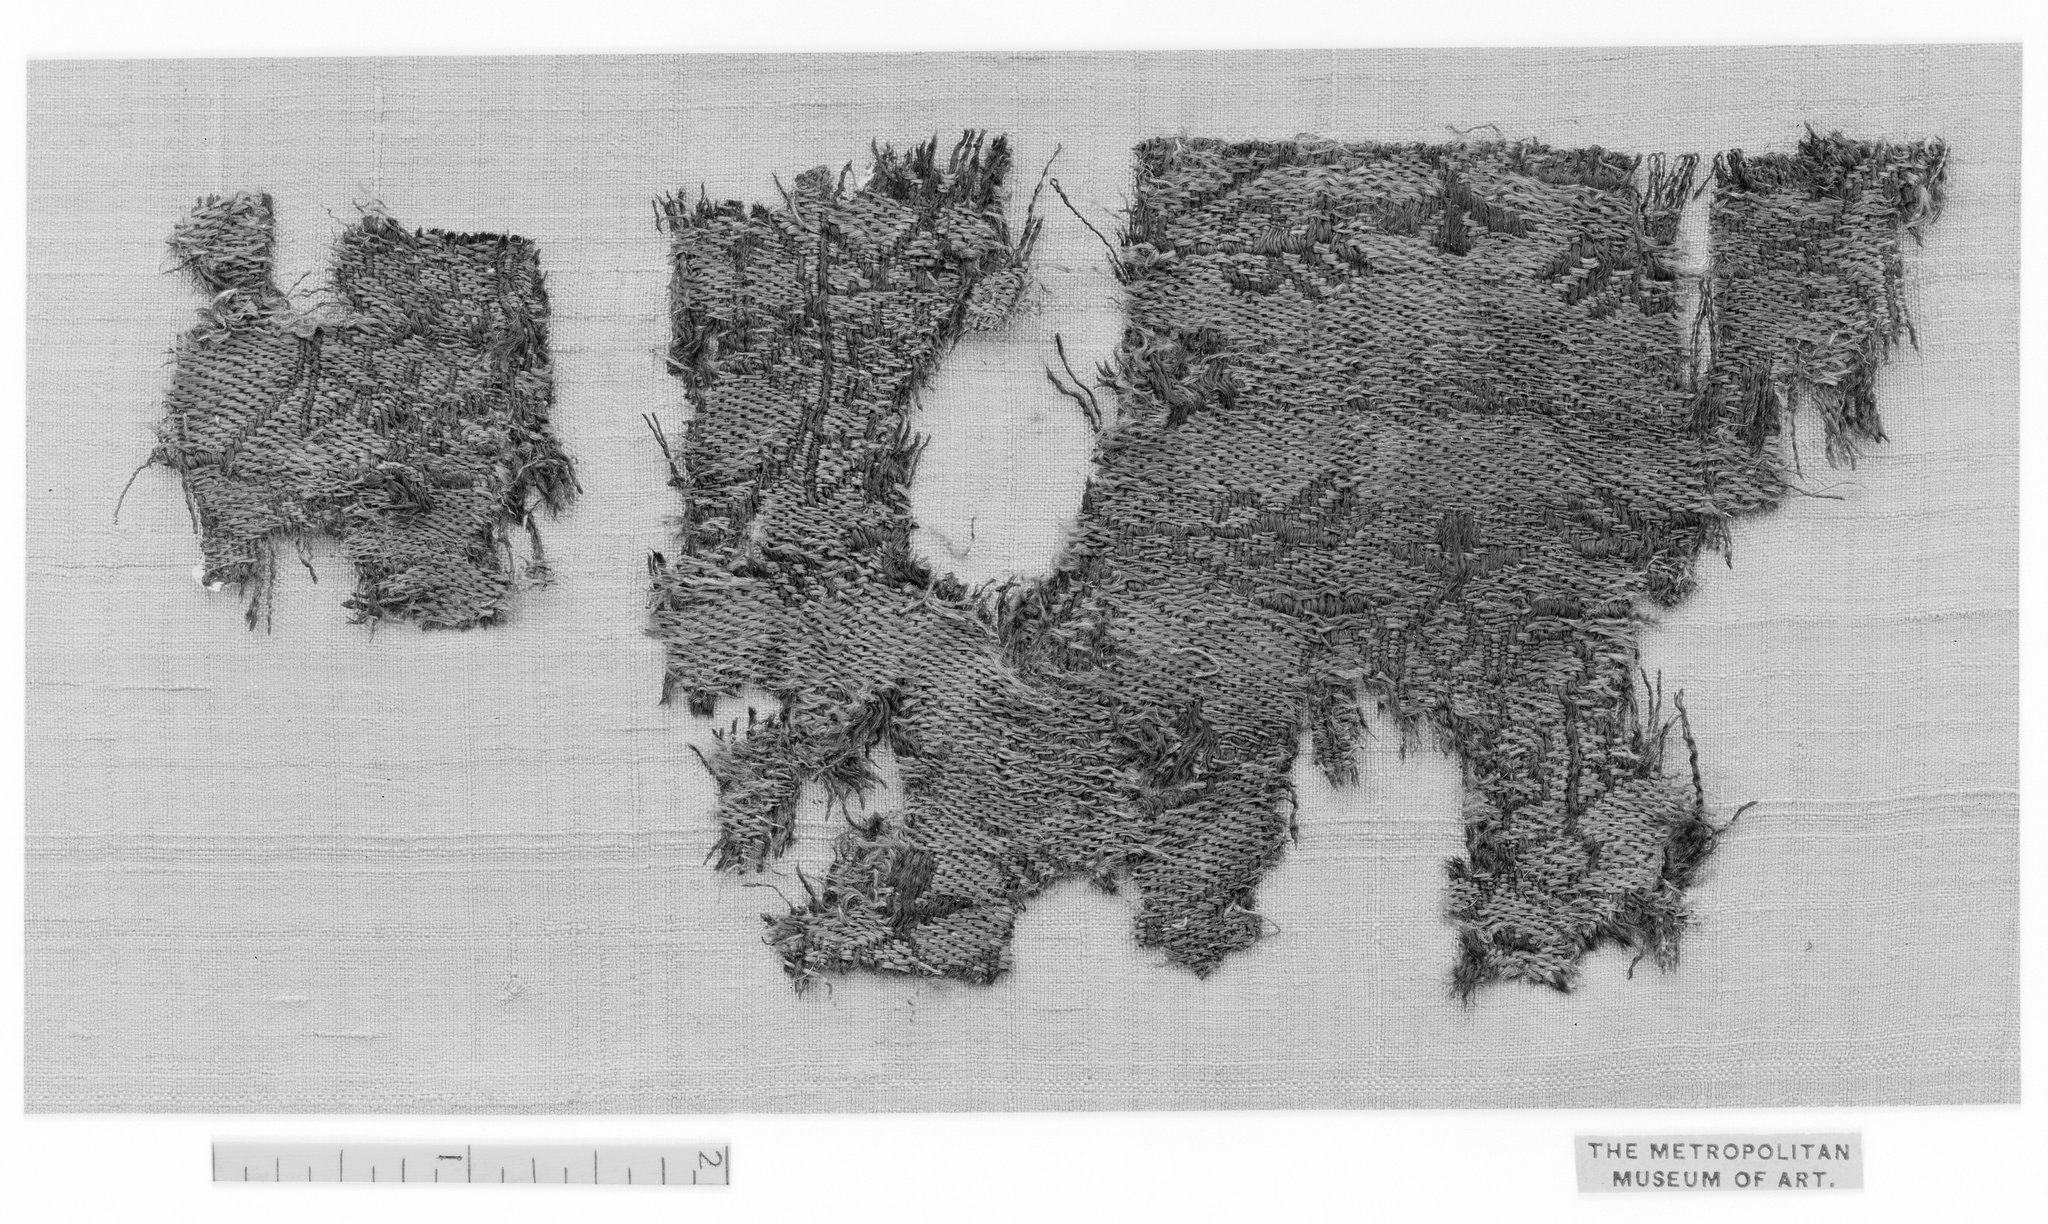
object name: textile fragment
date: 801-1000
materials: silk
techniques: lampas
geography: egypt